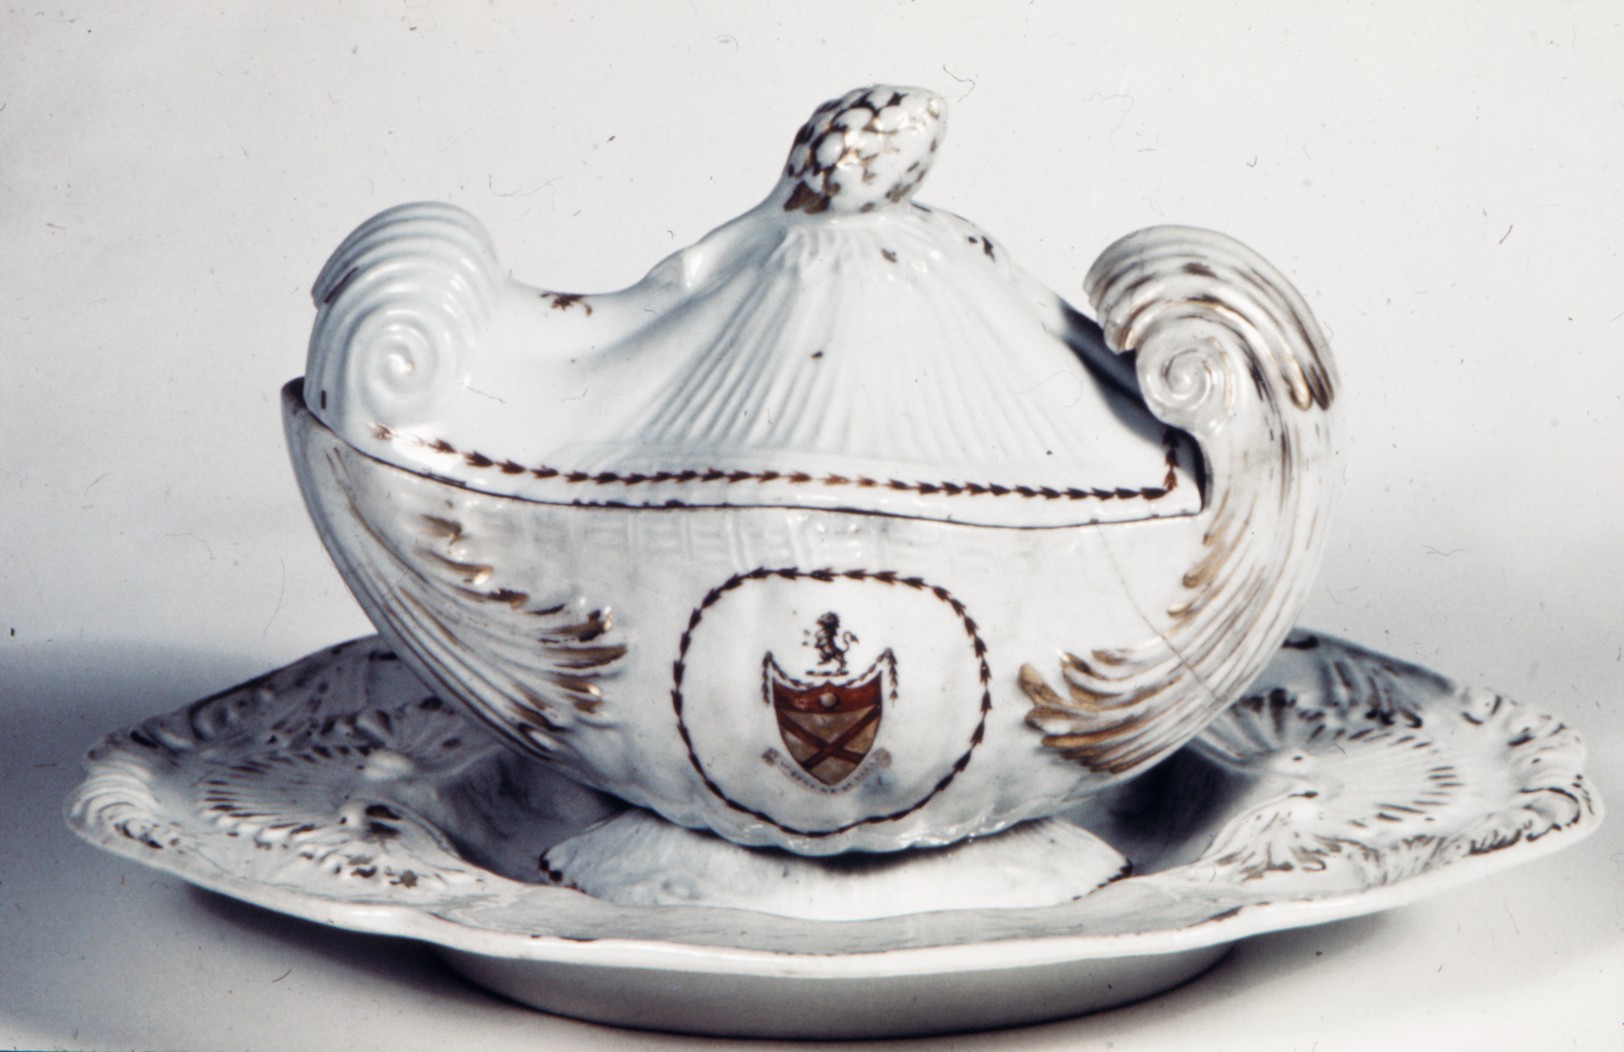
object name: sauceboat with cover and tray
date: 1785-1800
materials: hard paste porcelain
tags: coat of arms